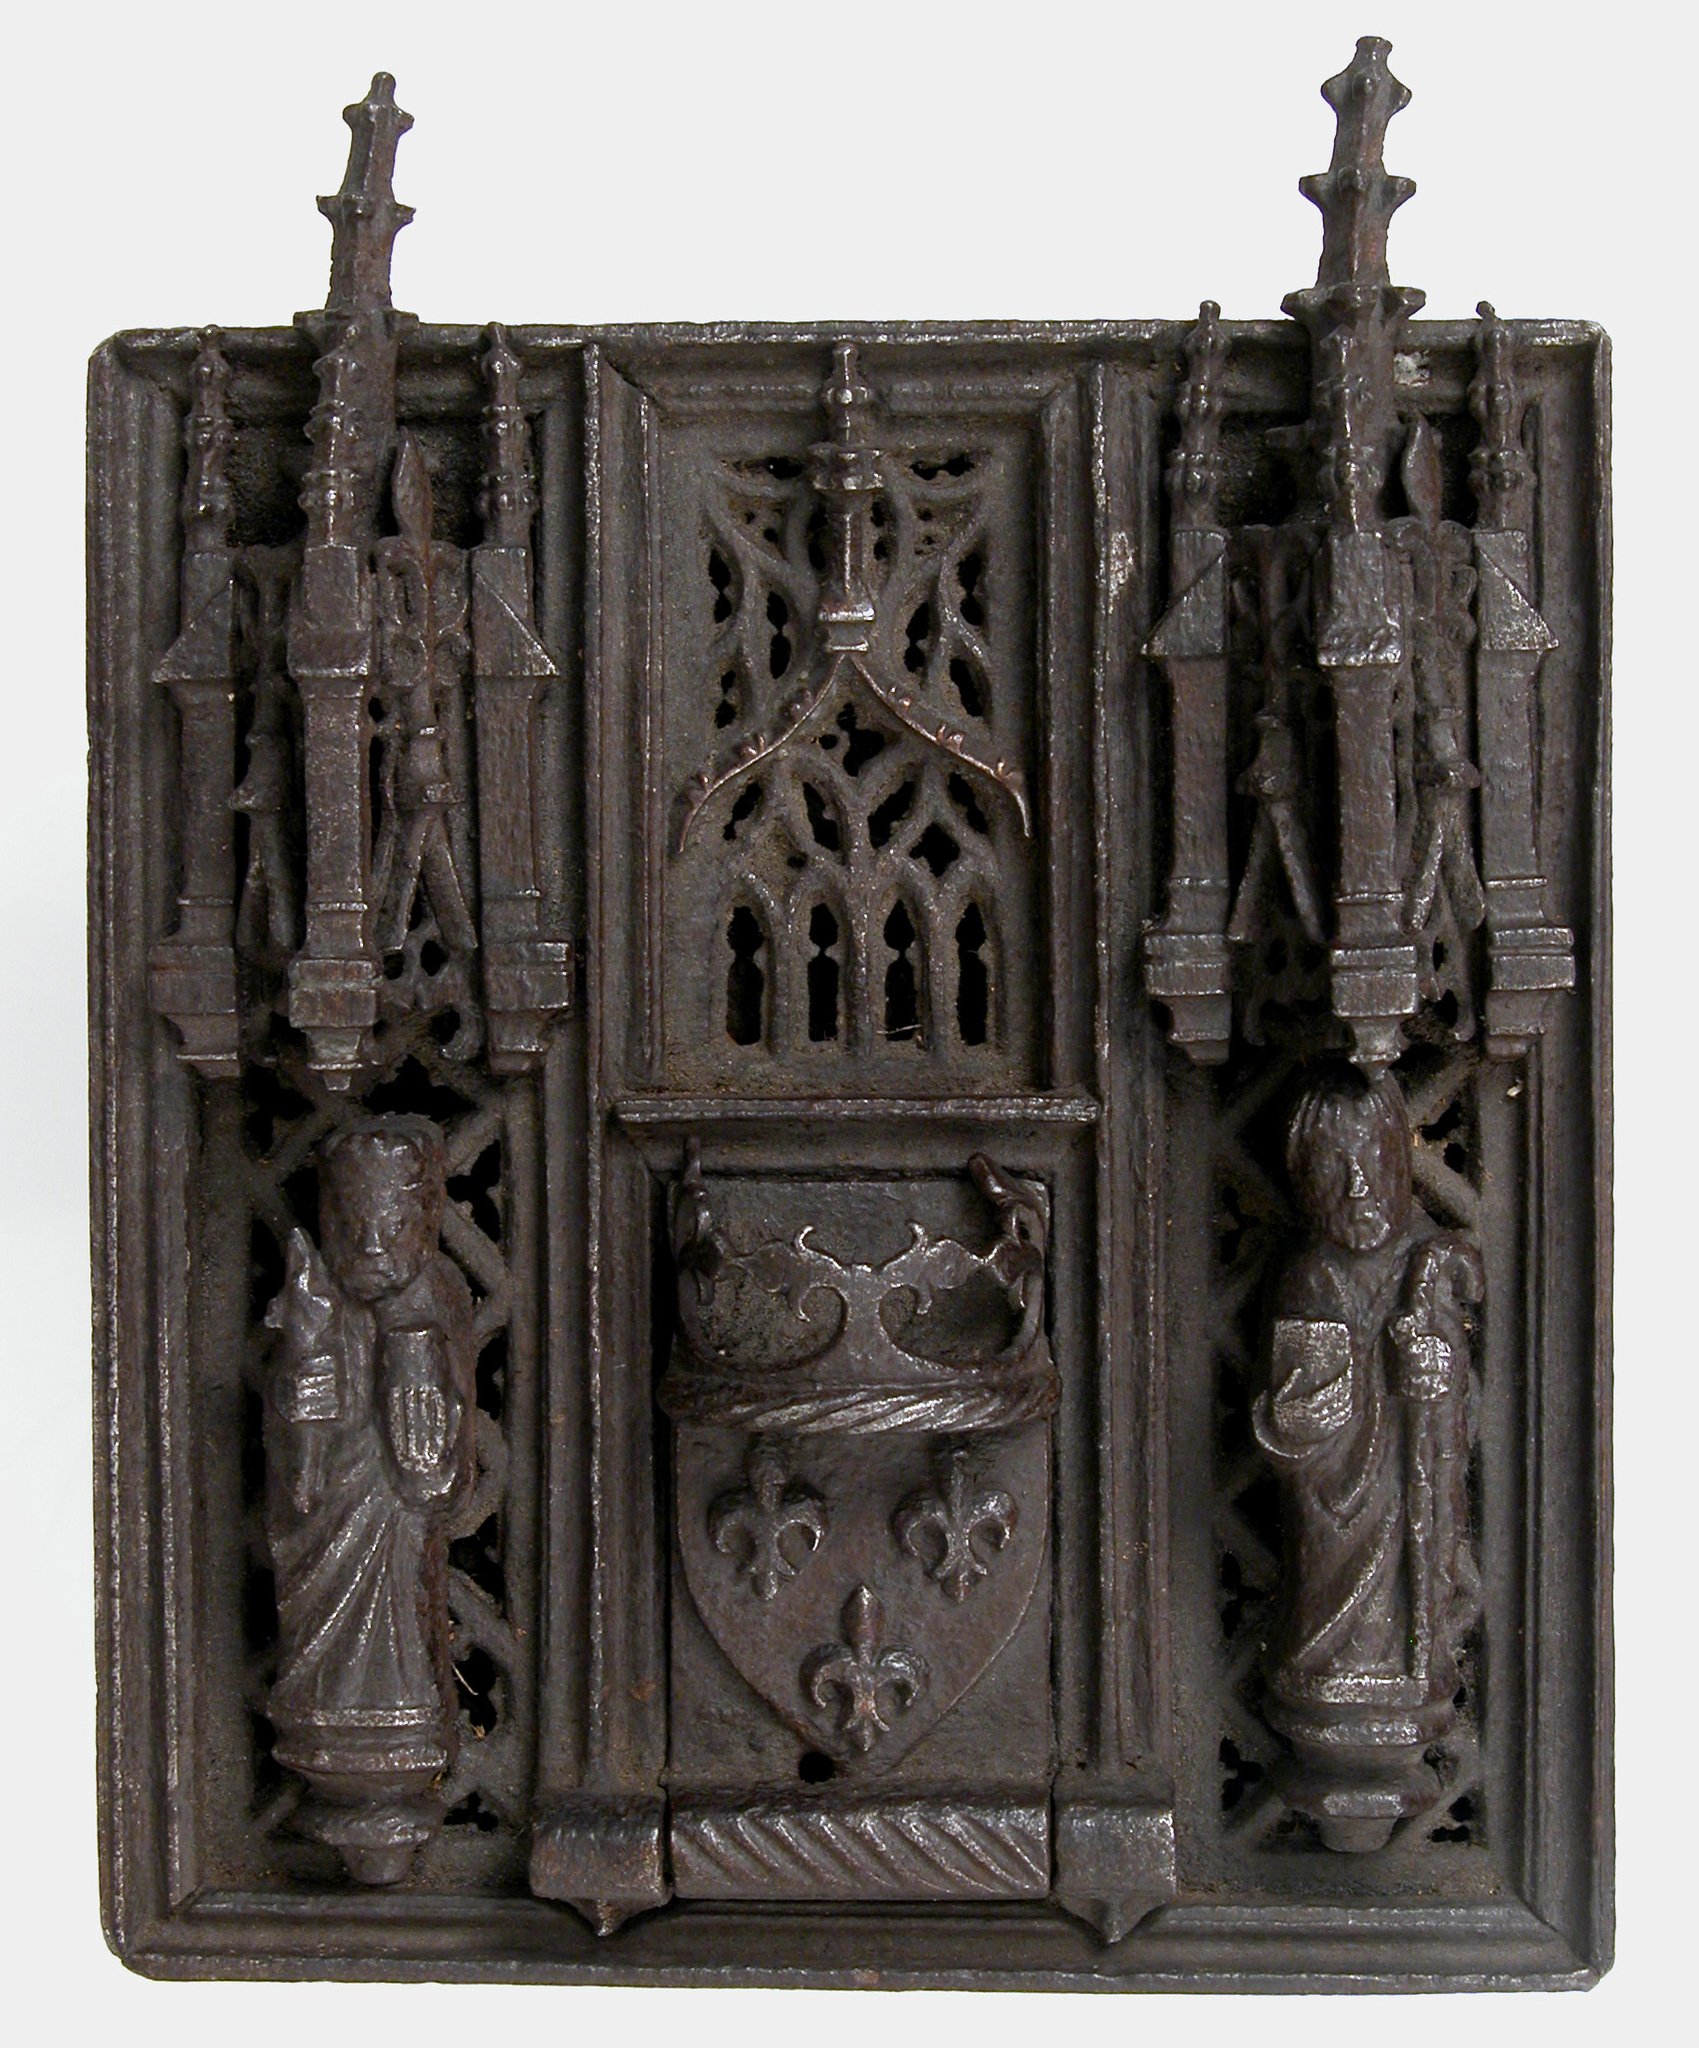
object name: lock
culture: french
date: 1301-1400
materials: iron